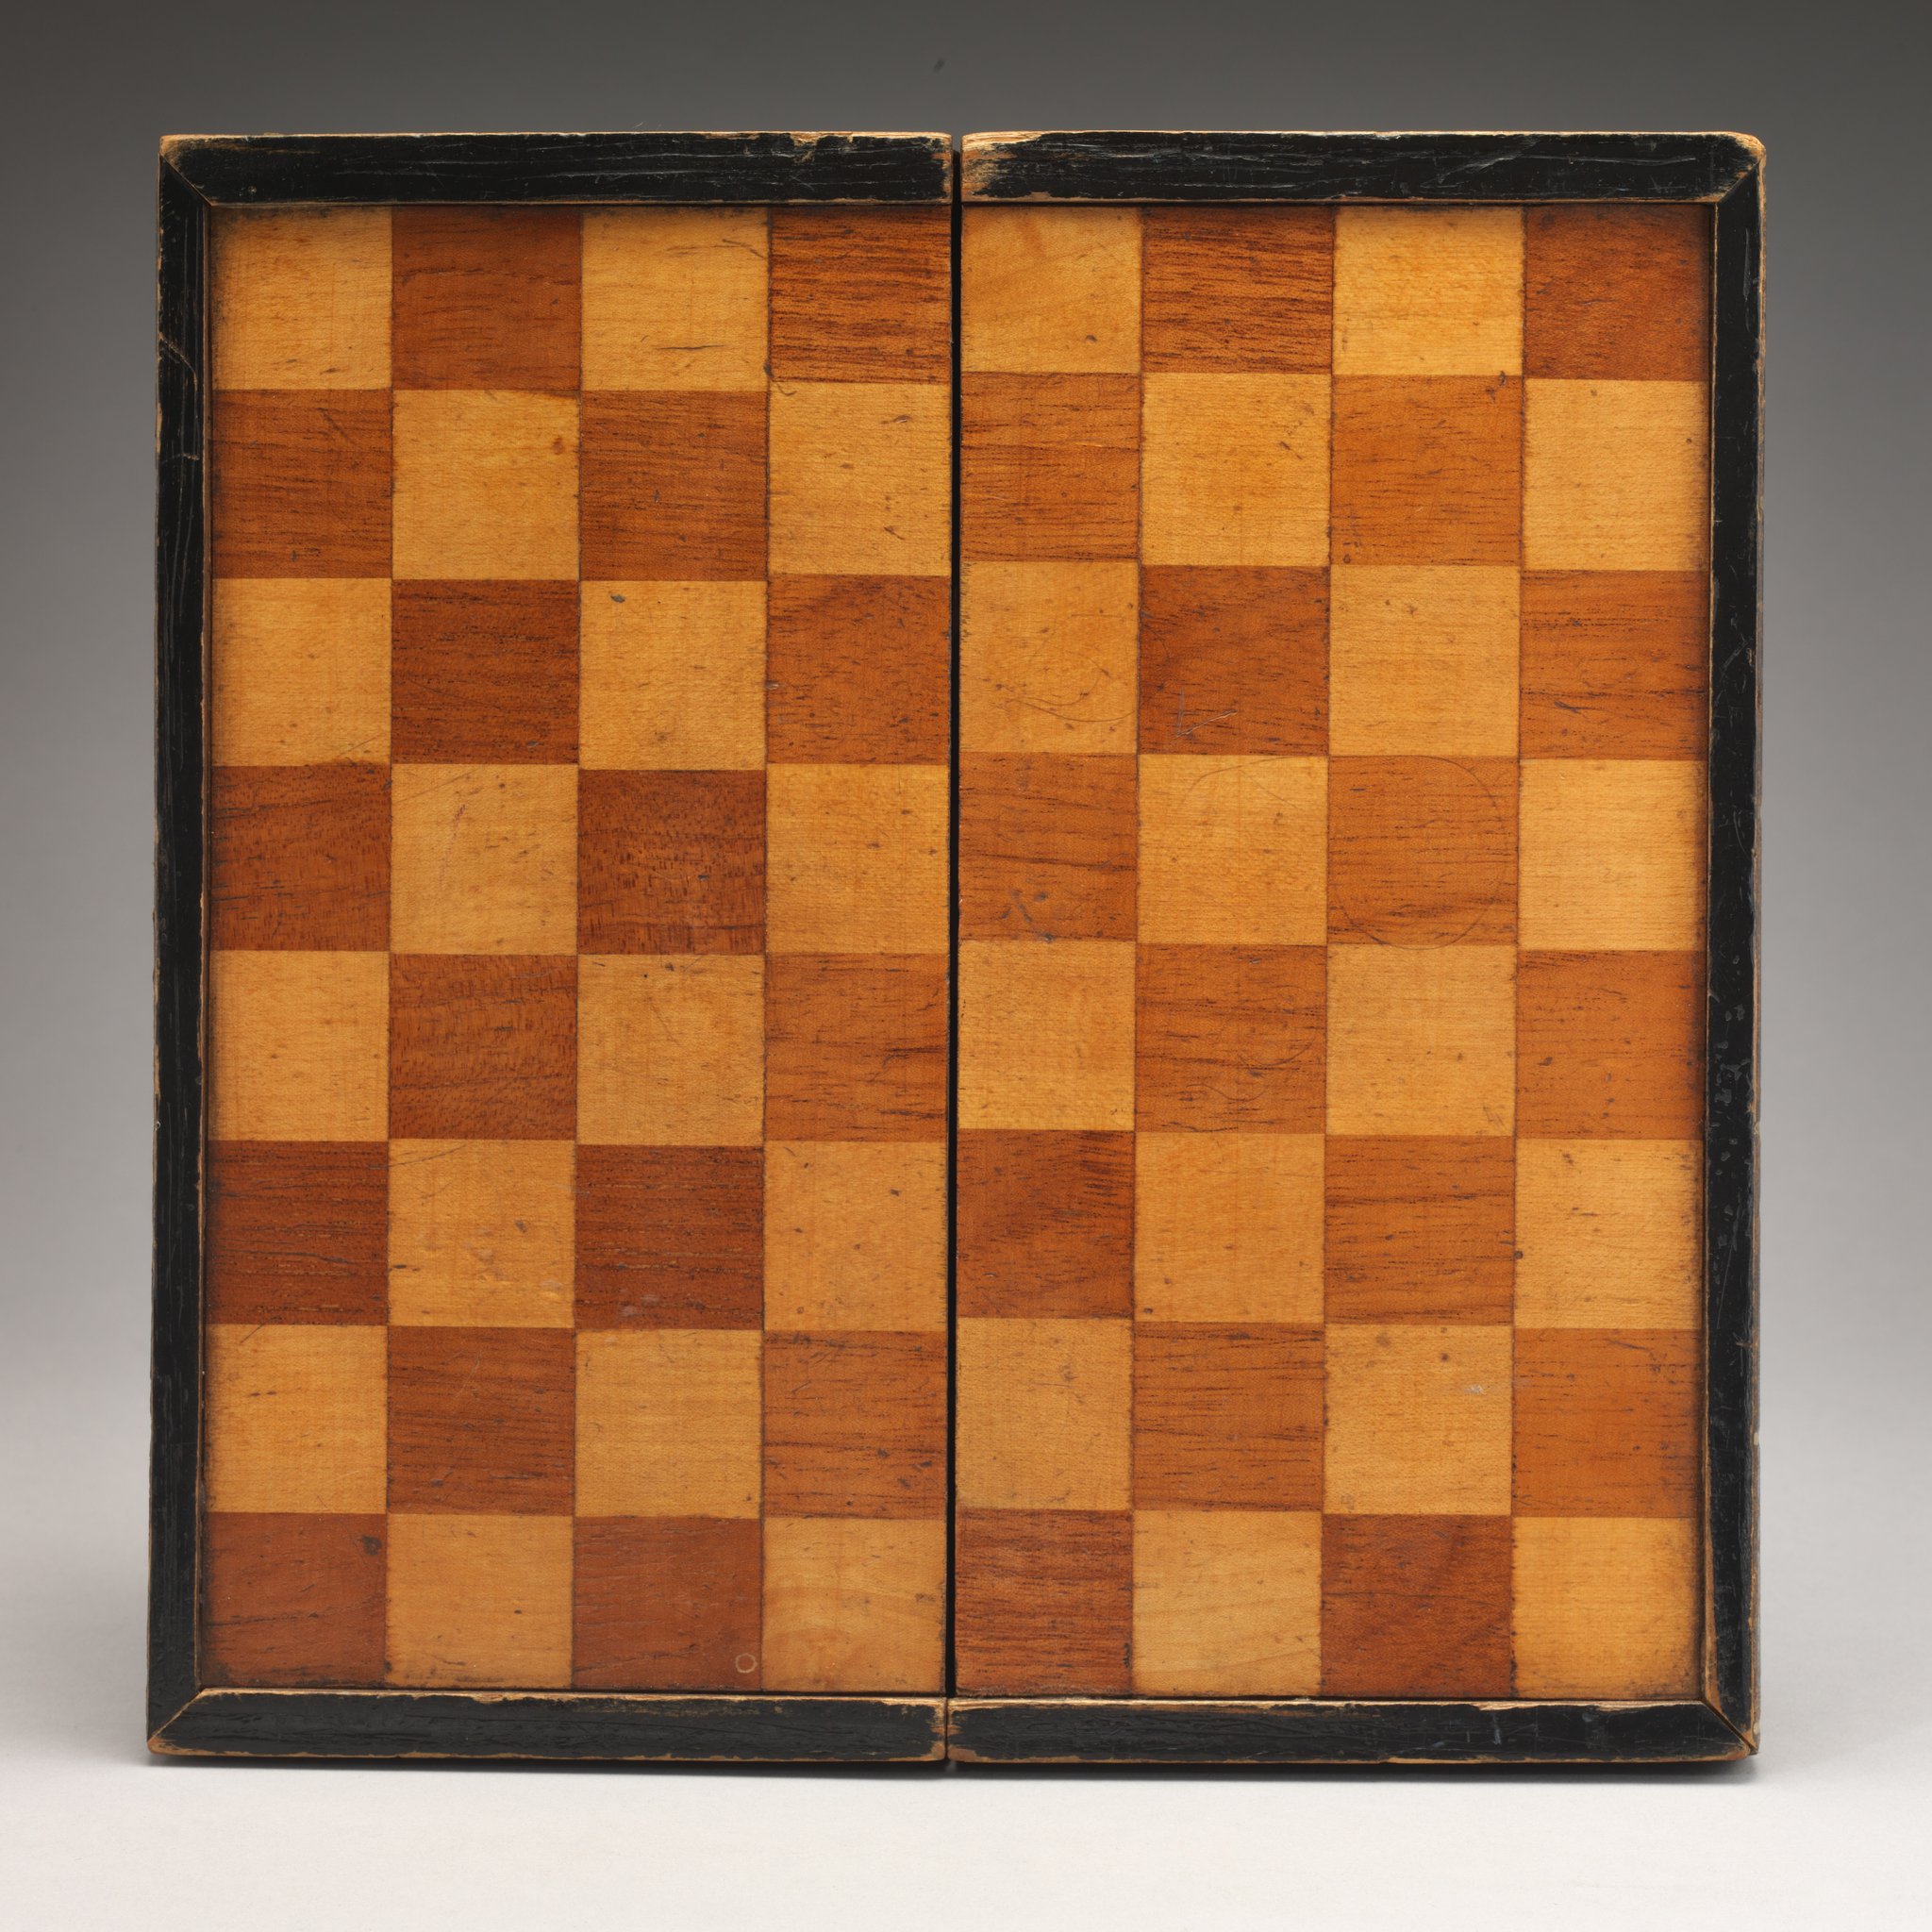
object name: chess box board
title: Chess box-board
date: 1867-1900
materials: leather, wood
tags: chess